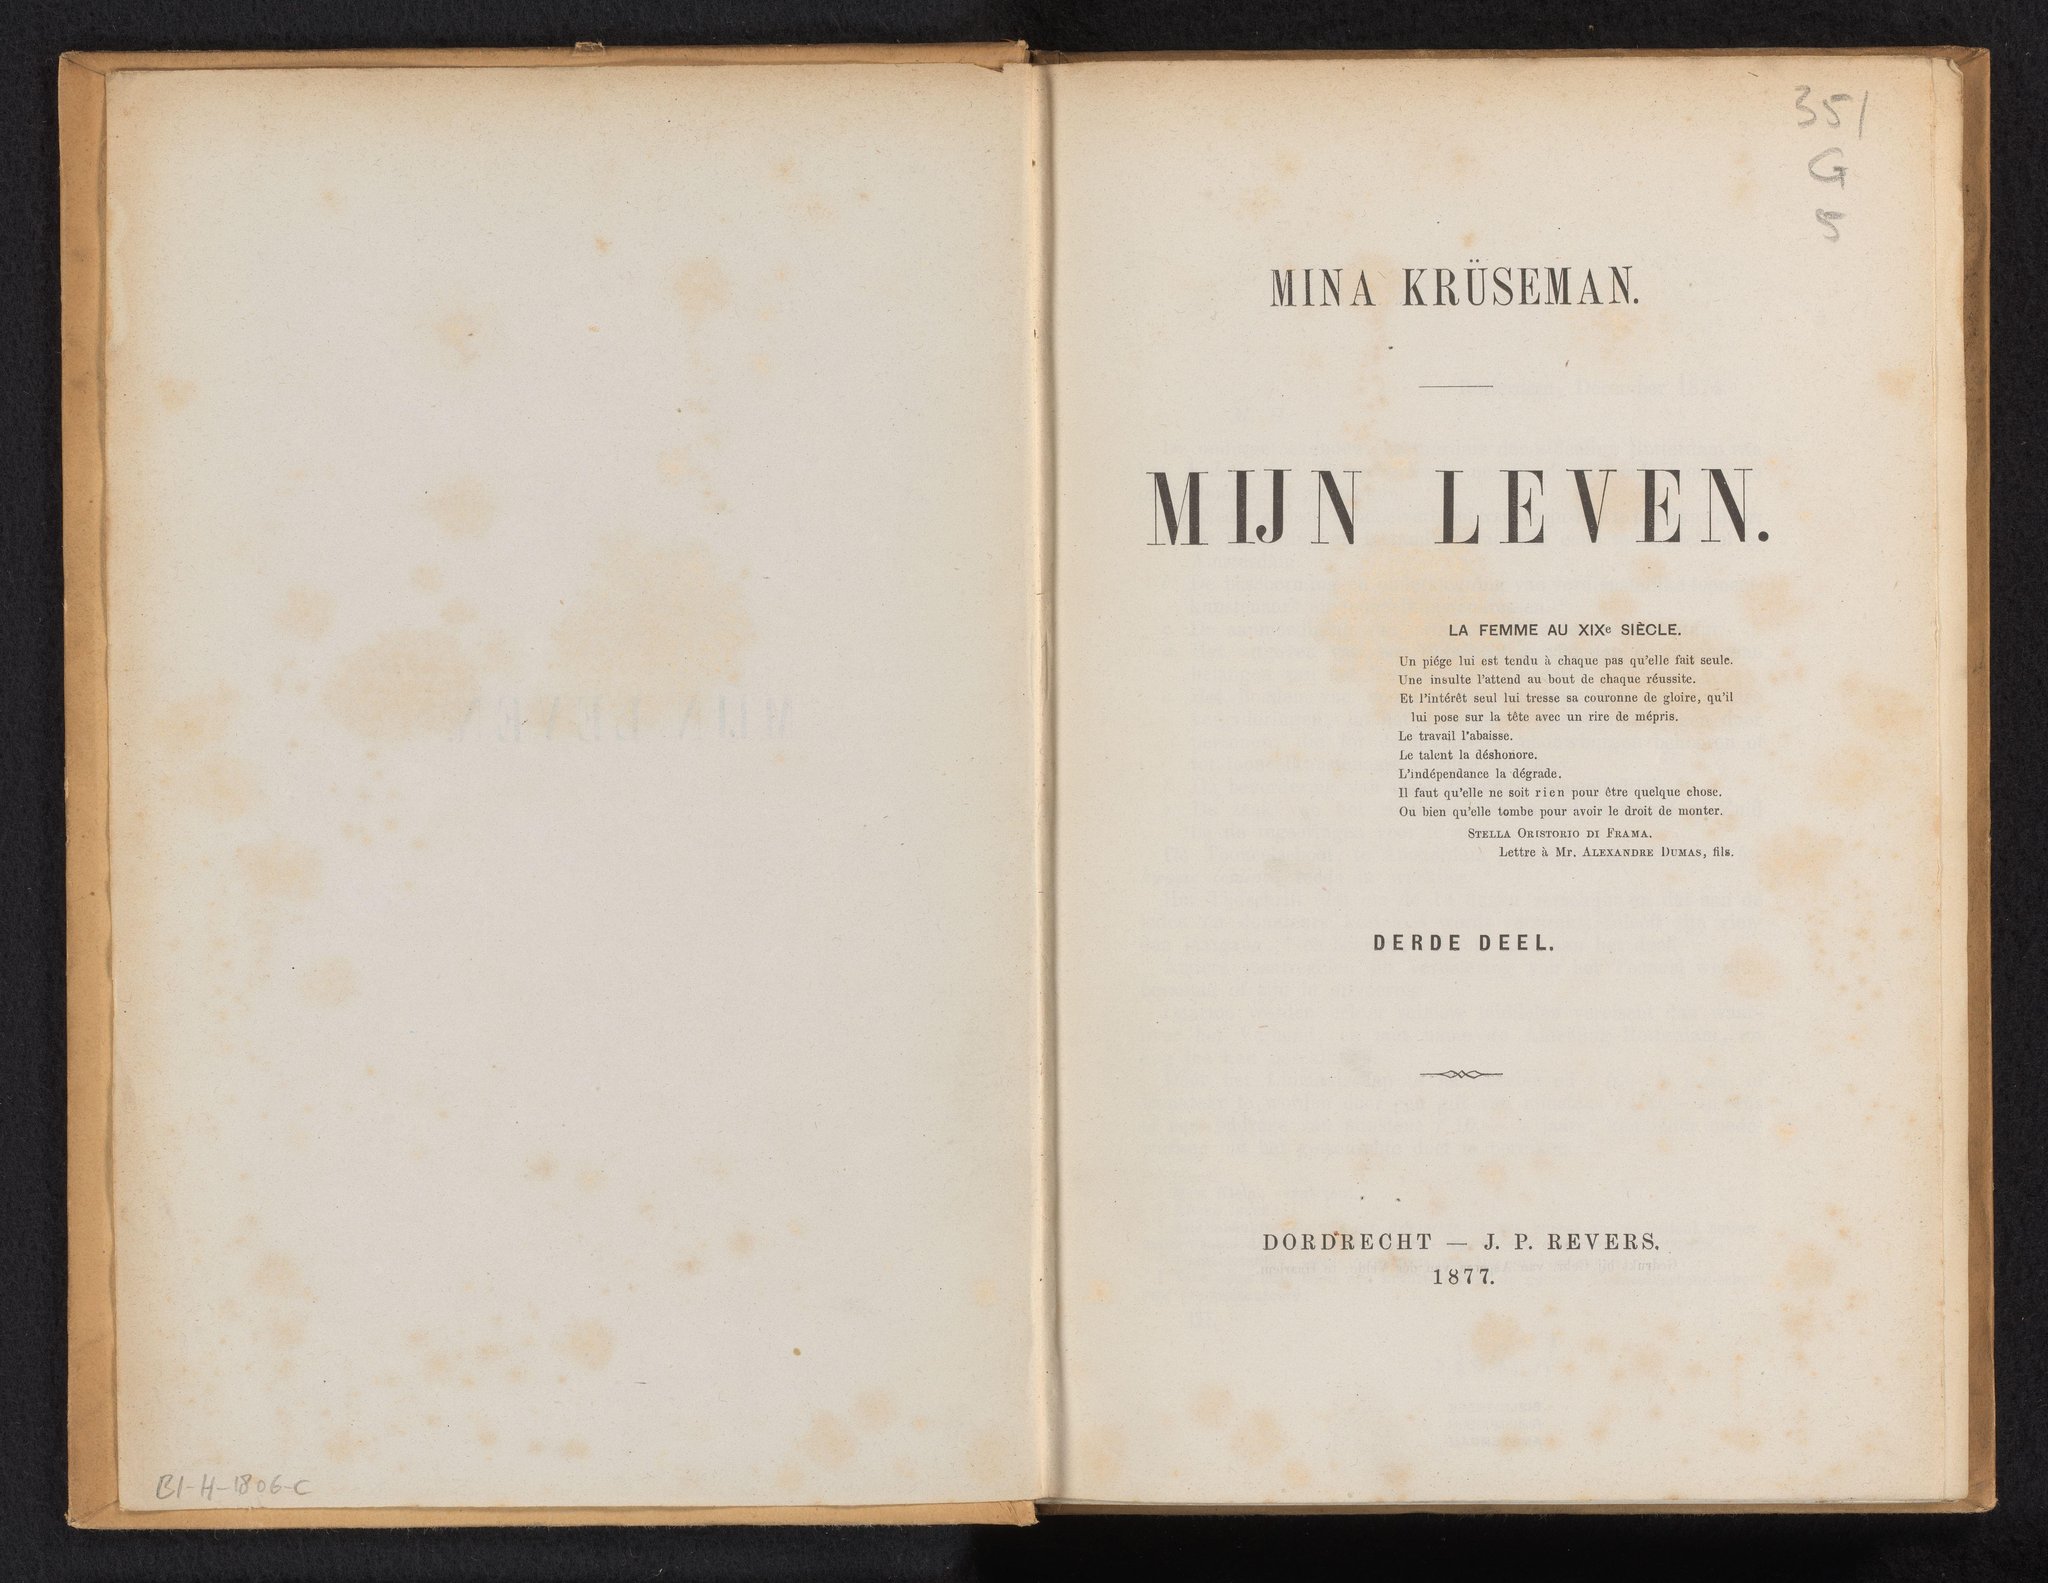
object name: book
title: Mijn leven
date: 1877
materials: cardboard, paper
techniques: printing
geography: dordrecht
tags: mina kruseman